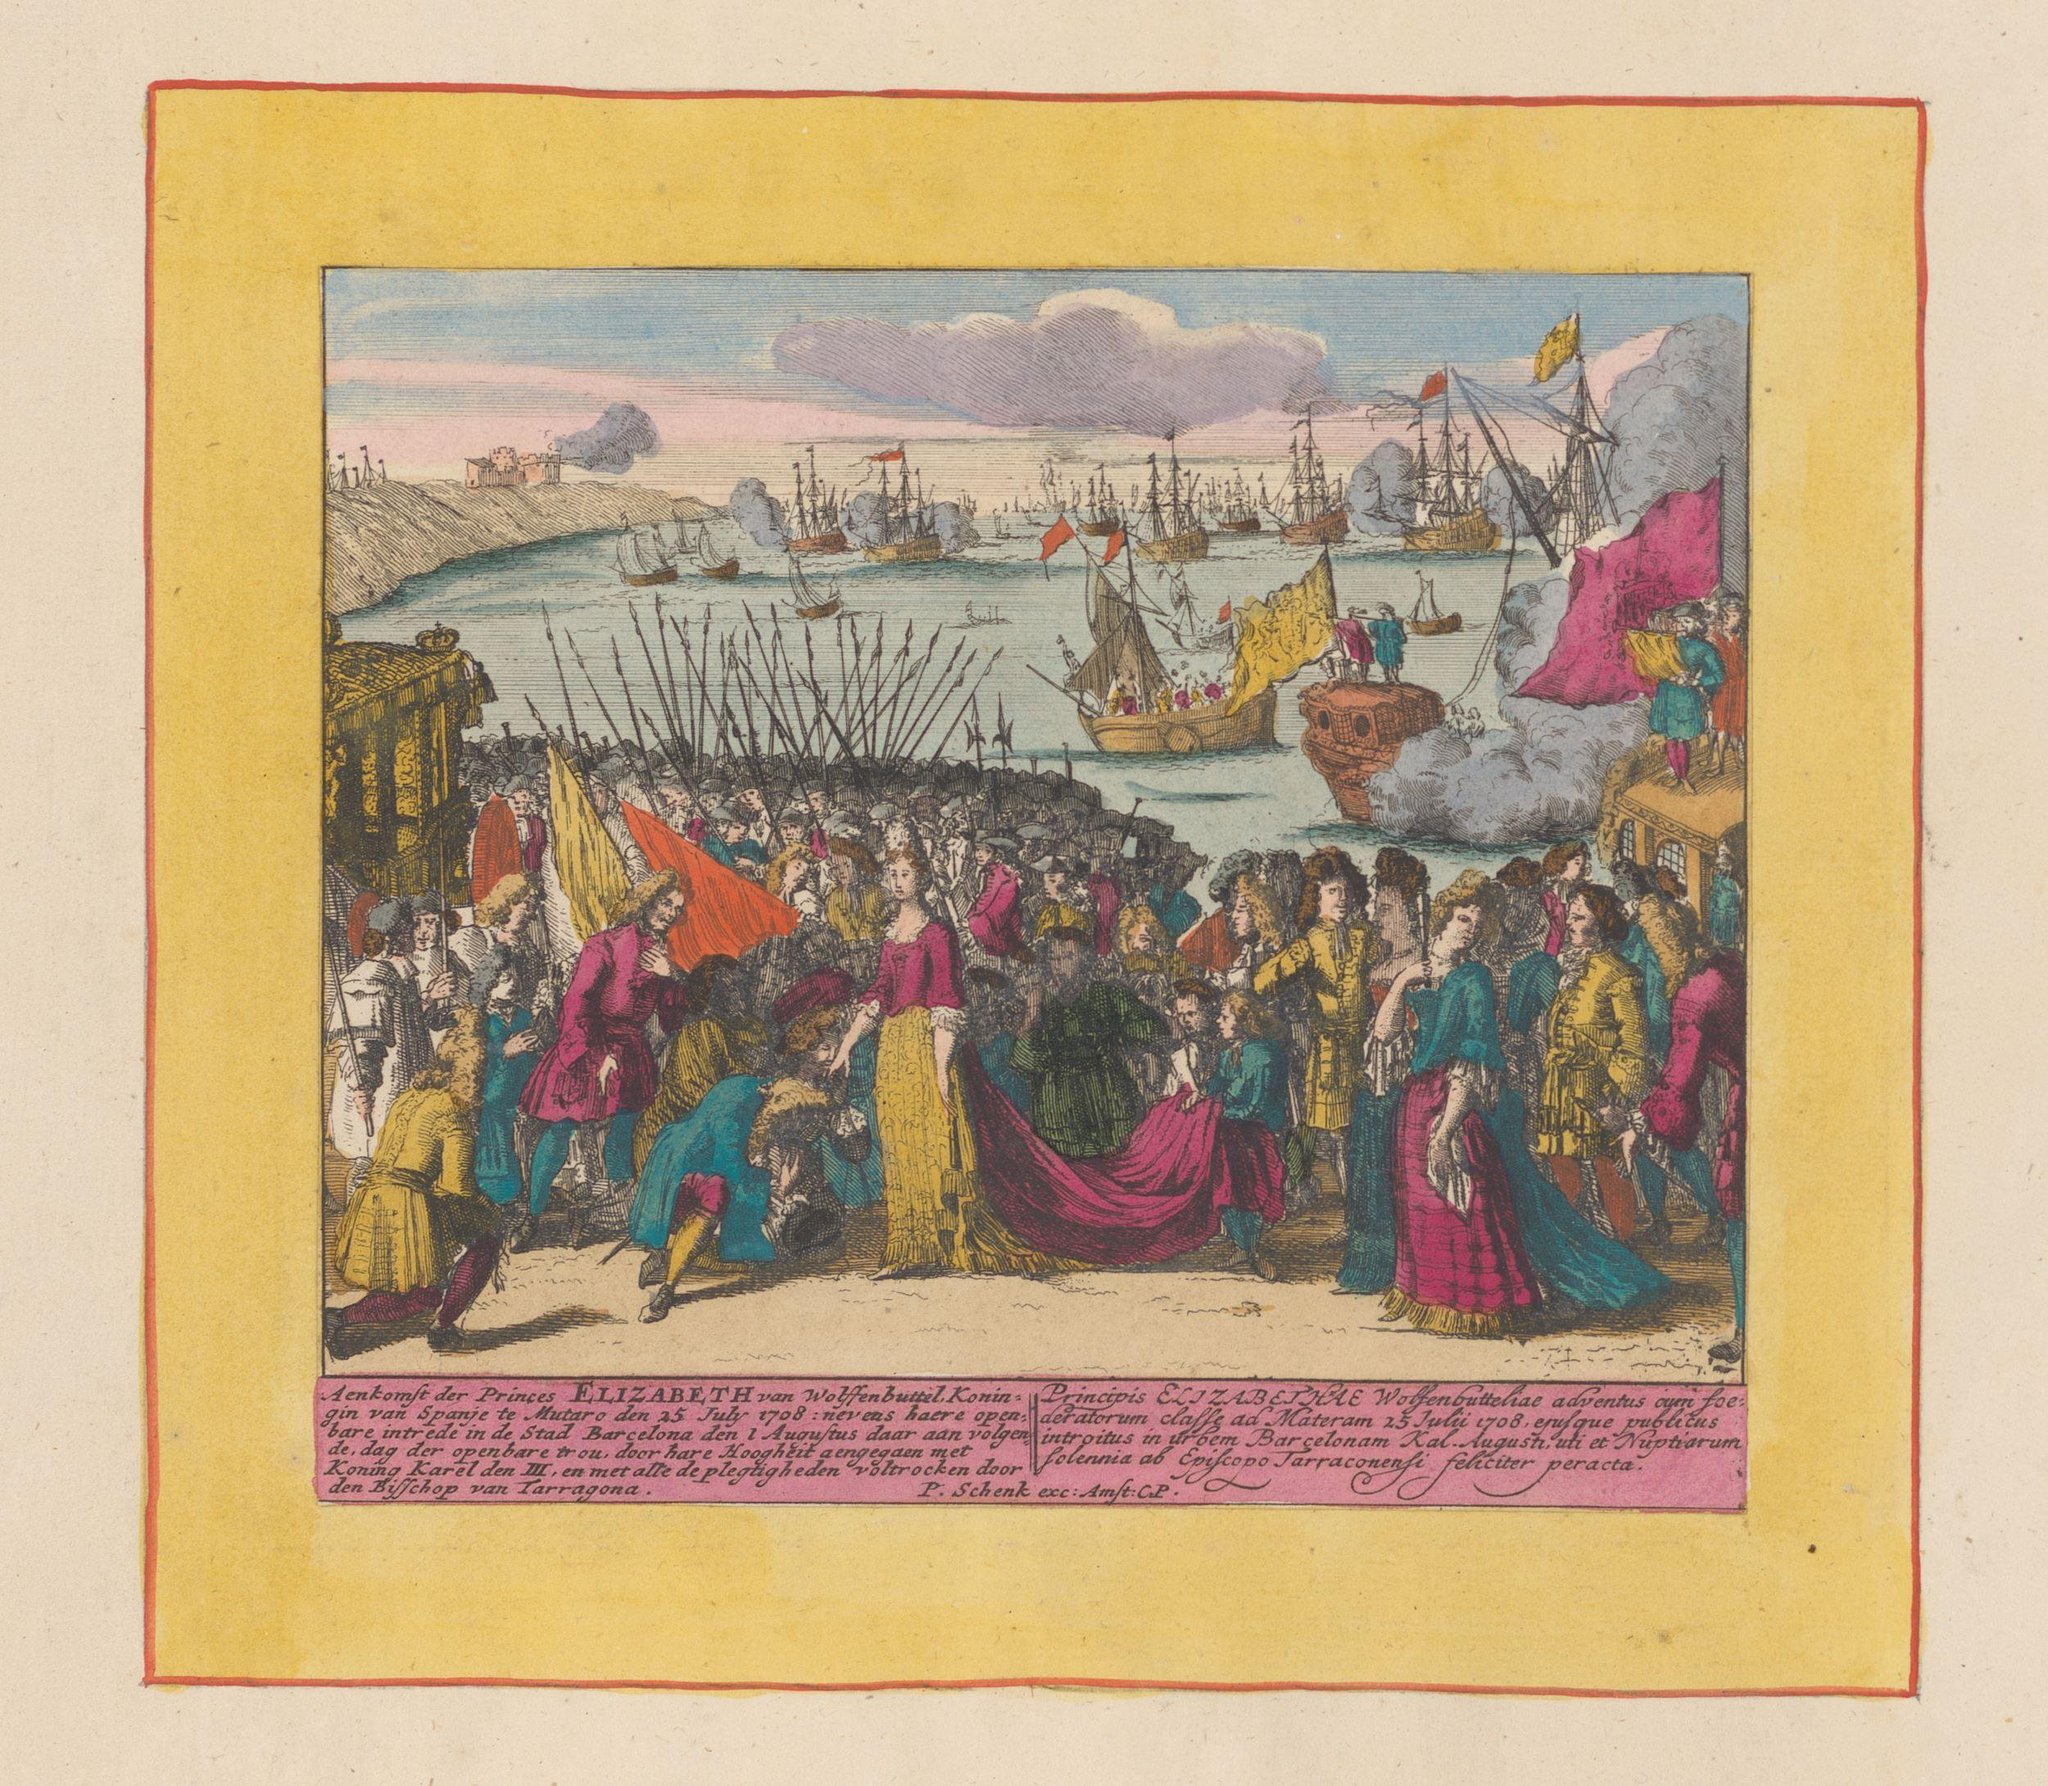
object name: album leaf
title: Aankomst van Elisabeth Christine van Brunswijk-Wolfenbüttel in Mutaro, 1708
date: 1707-1720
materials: paper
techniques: etching, hand coloring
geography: amsterdam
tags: arrival and return ~ travelling, spain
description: Prent uit: Schouwburg van den oorlog, beginnende van Karel den II. tot op koning Karel den III. : bestaande in IX historische figuren op een olifants blad, als veldslagen, belegeringen te water en te lande, met de voornaamste vestingen. Amsterdam: Pieter Schenk, 1709.